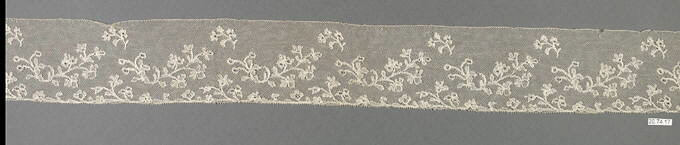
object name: fragment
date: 1801-1833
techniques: lace